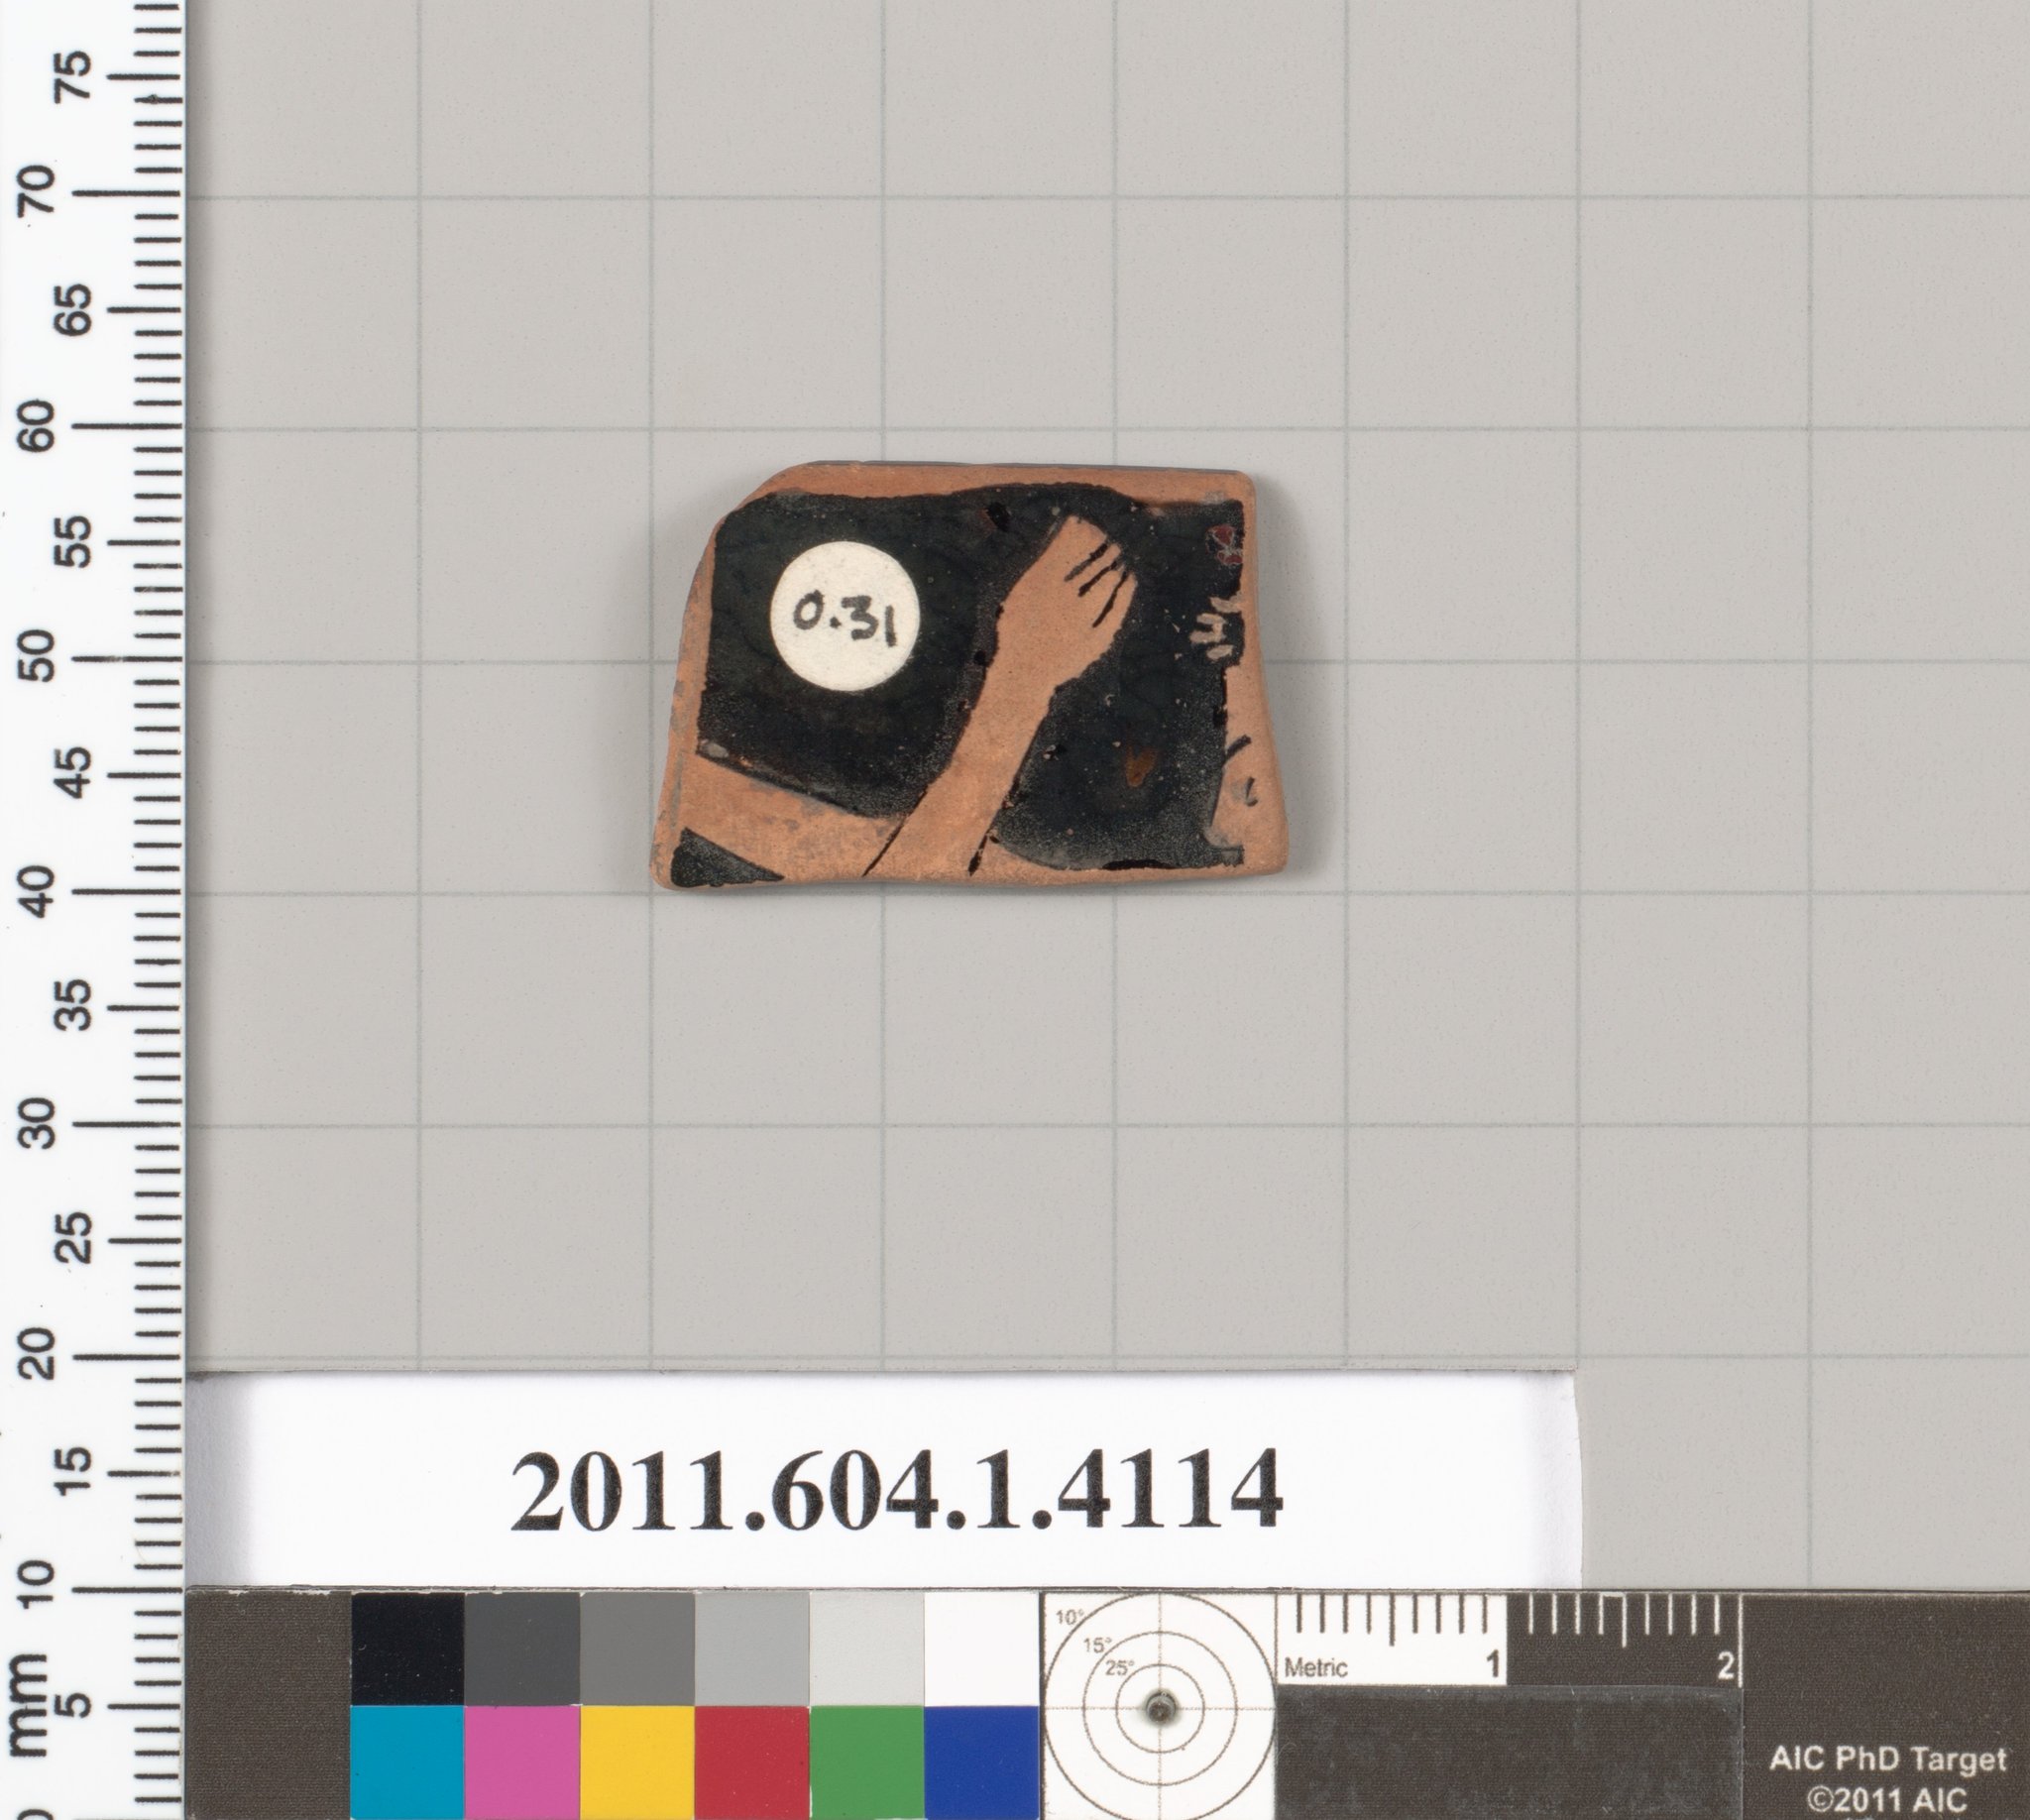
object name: kylix fragment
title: Terracotta rim fragment of a kylix (drinking cup)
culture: greek, attic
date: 500-480 BCE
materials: terracotta